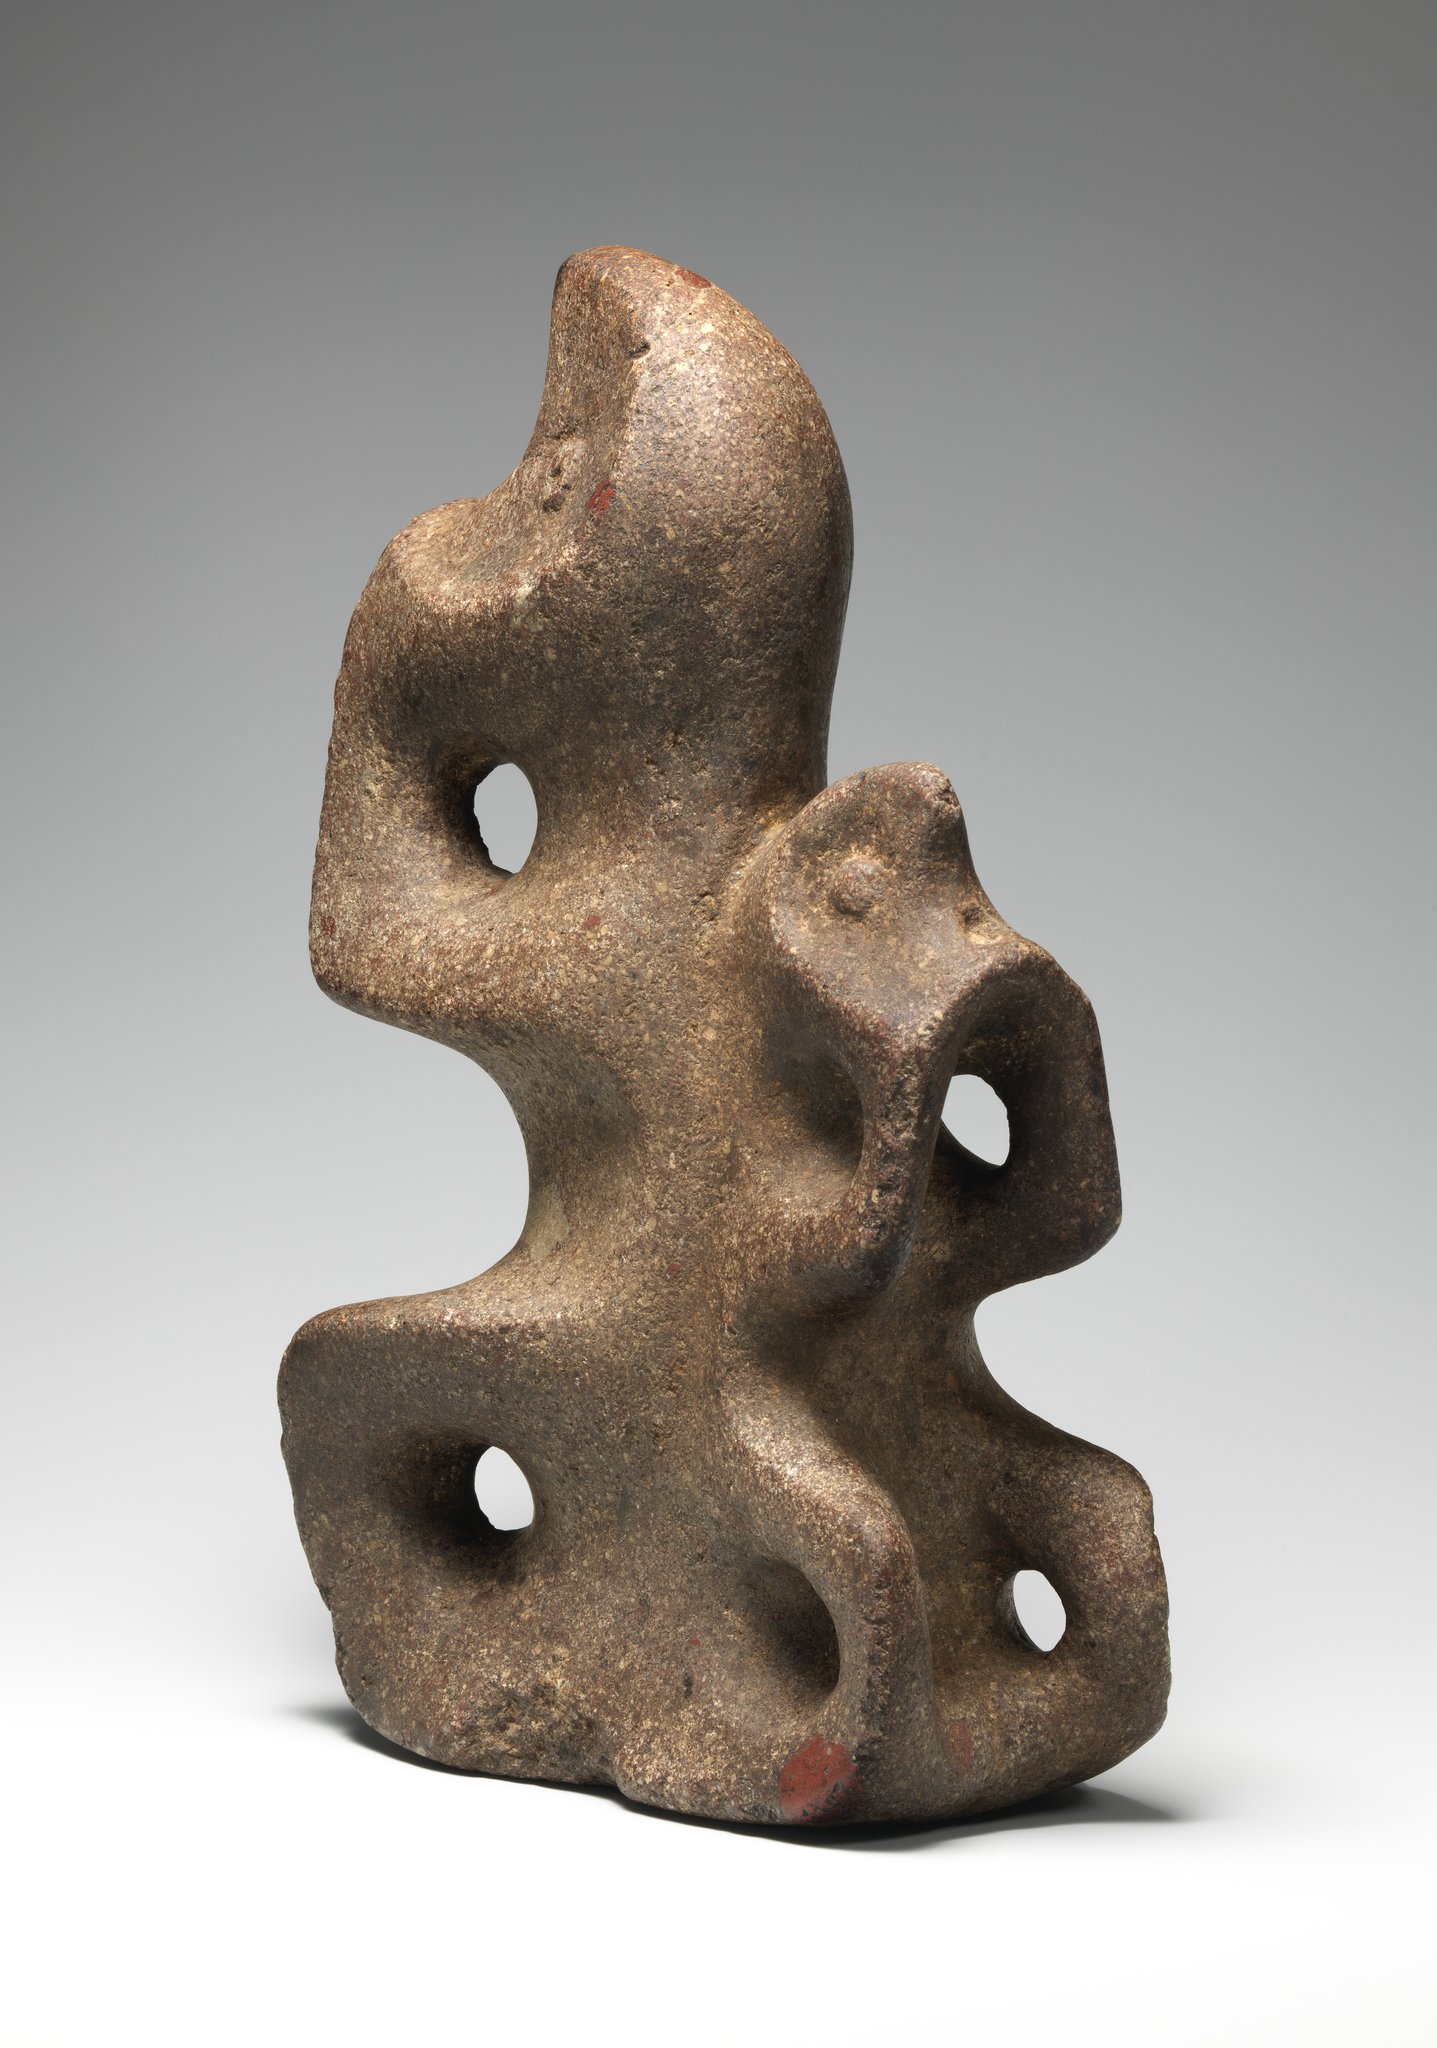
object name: sculpture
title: Sculpture in the shape of two figures (suplicante)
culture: alamito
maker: alamito artist(s)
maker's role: artist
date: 500 BCE-500 CE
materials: stone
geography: argentina